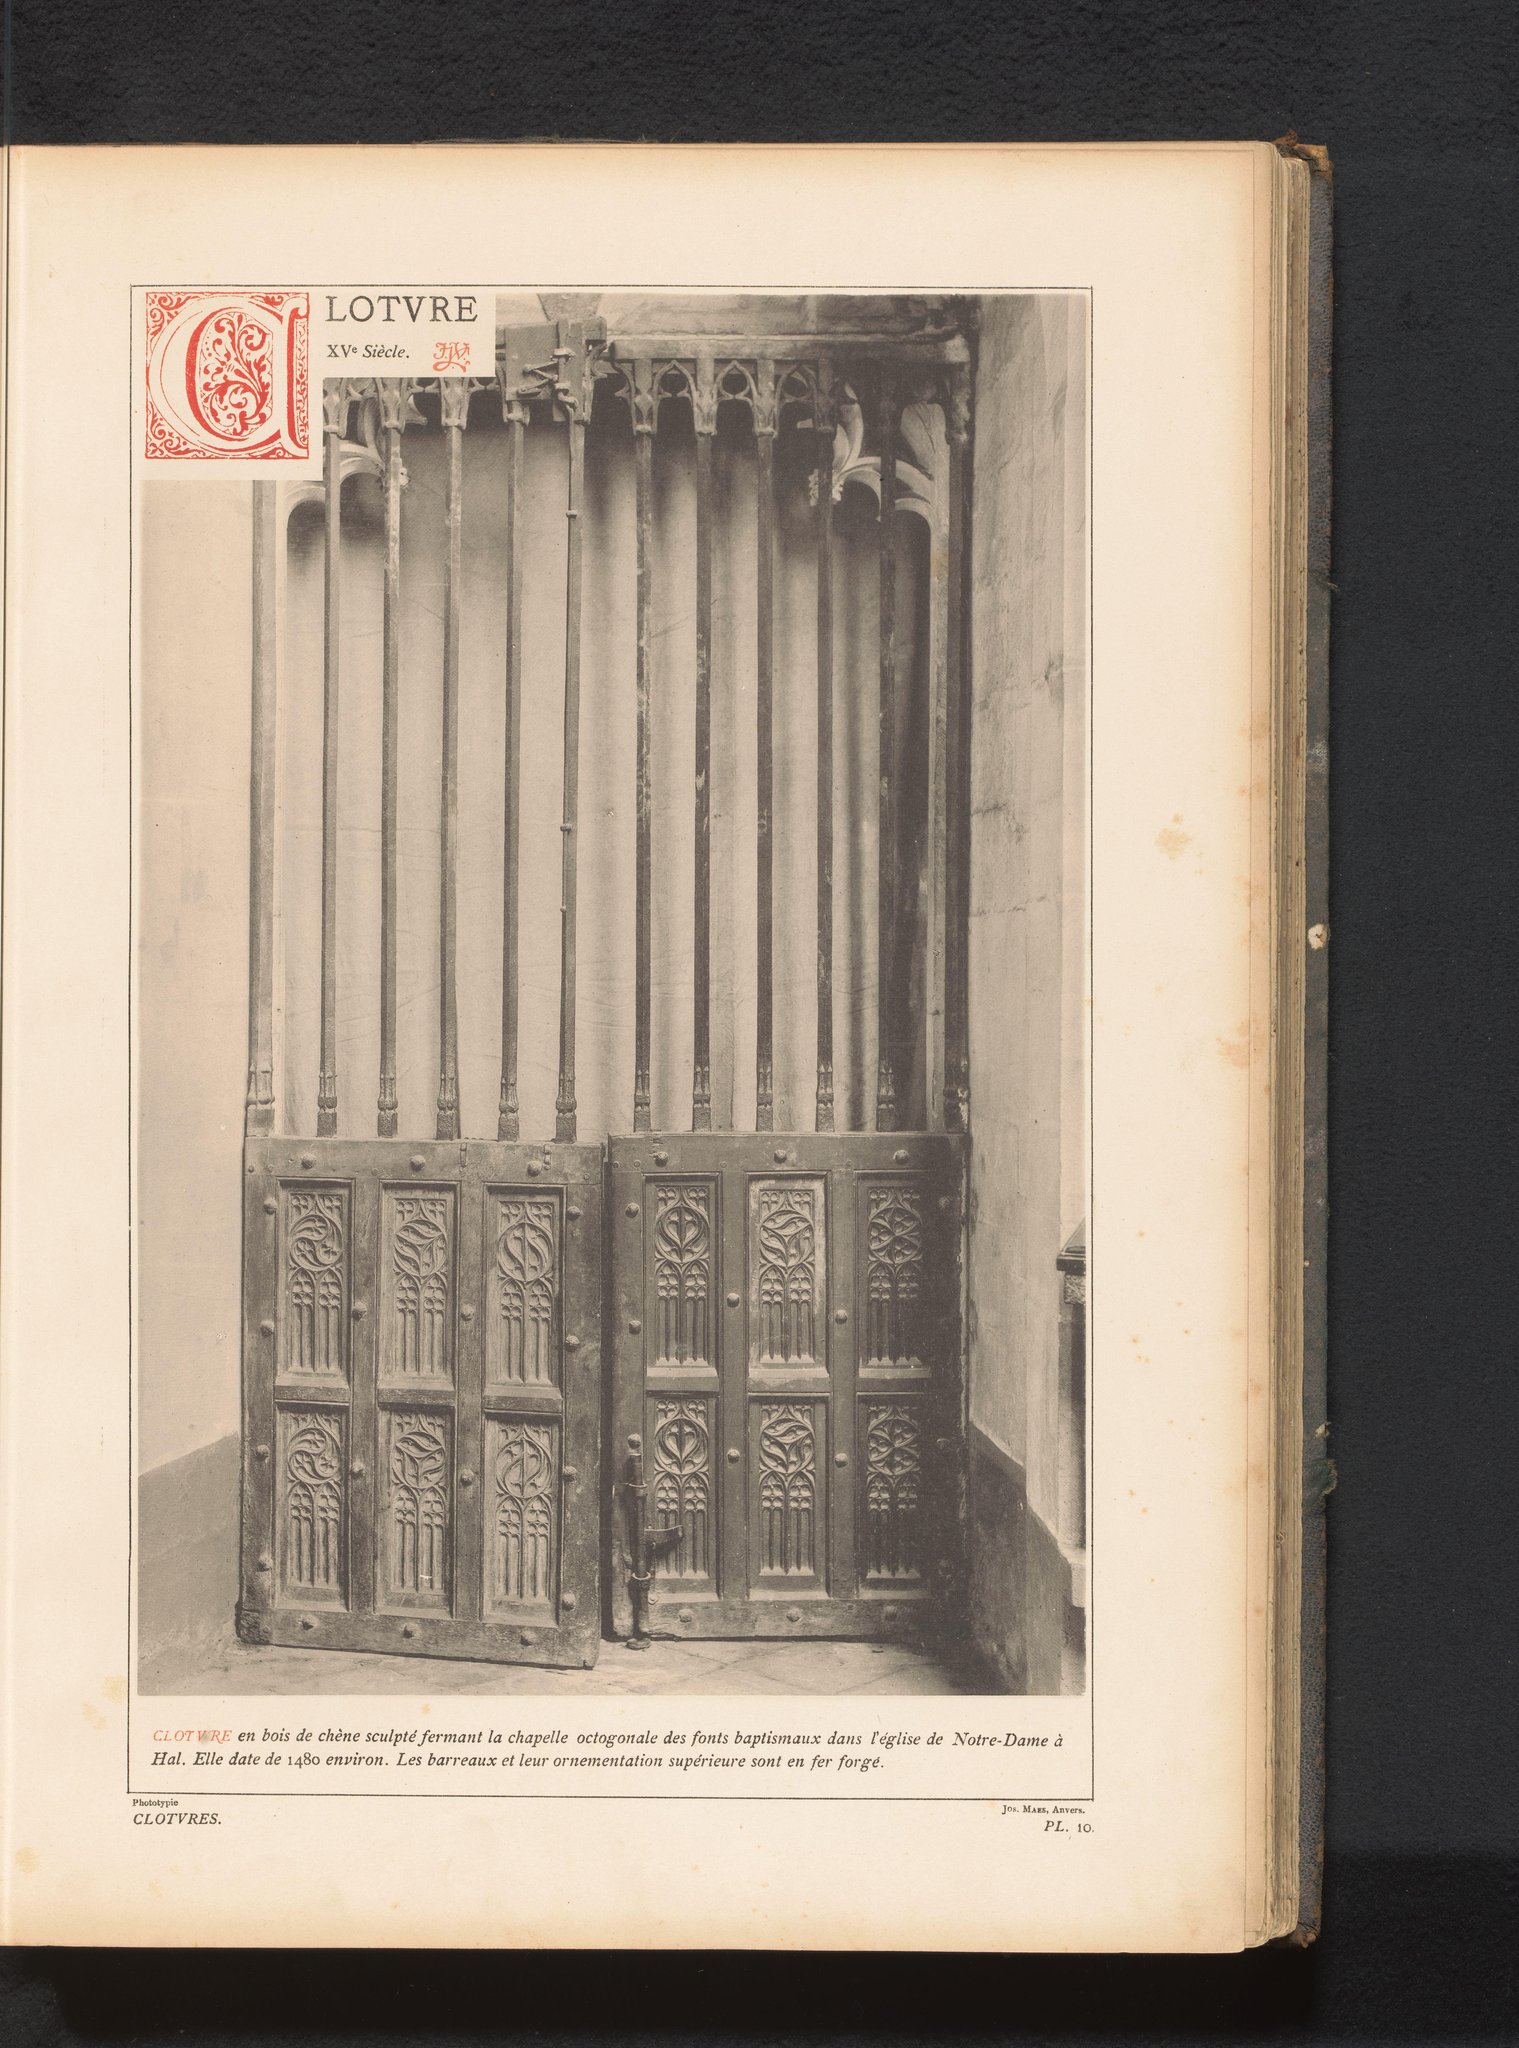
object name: photomechanical print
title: Koorhek in de Sint-Martinusbasiliek in Halle, België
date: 1882-1887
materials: paper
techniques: photograph, photolithography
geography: sint-martinusbasiliek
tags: parts of church interior: choir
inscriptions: monogram: ‘JJvY’, inscription: ‘CLOTURE en bois (...)’, inscription: ‘CLOTURES. - PL. 10.’